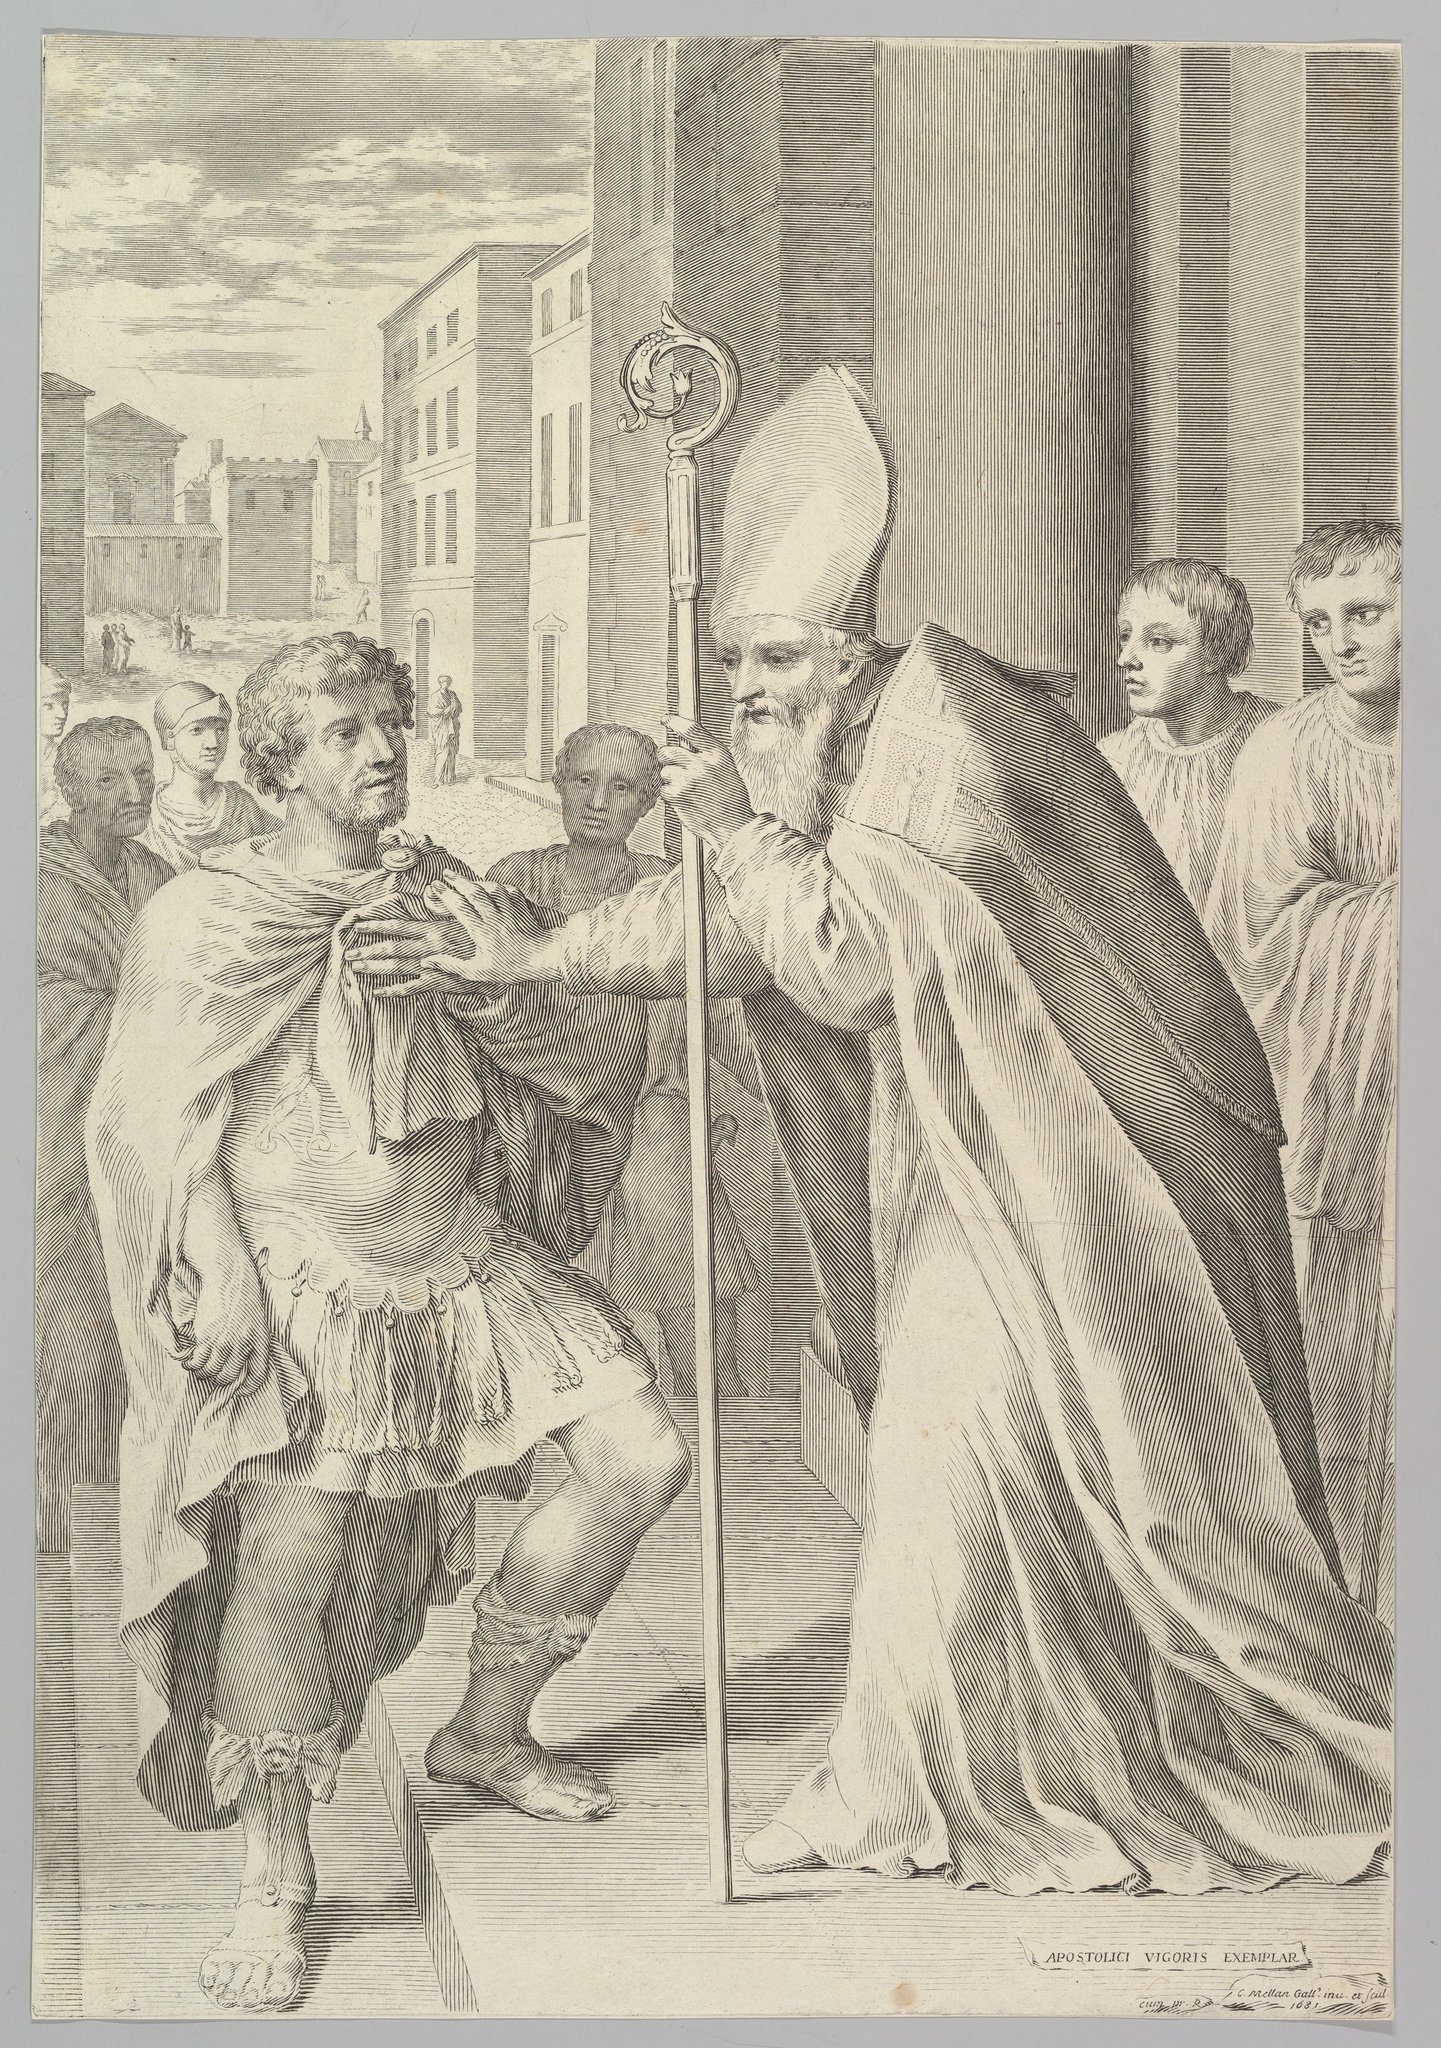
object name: print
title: St. Ambrose, Archbishop of Milan, Turning Back Emperor Theodosius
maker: claude mellan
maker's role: artist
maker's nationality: french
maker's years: 1598-1688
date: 1681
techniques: engraving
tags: men,saints